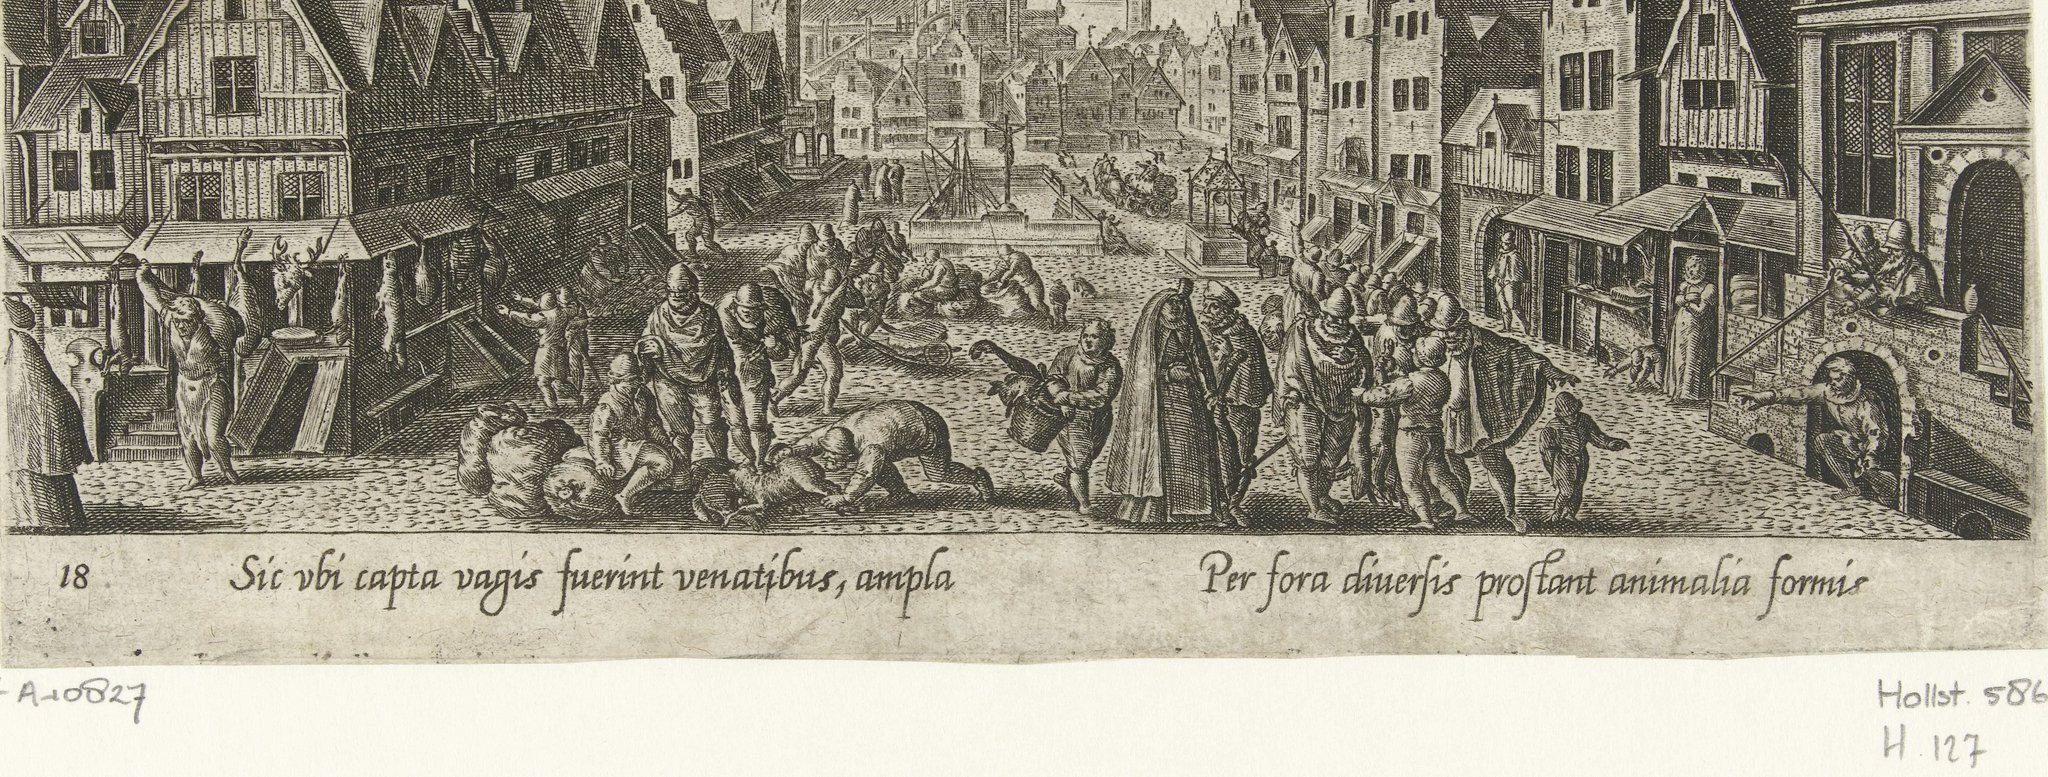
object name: print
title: Venationes, Piscationes et Aucupii Typi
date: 1582-1633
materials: paper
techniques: engraving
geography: antwerp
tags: butcher, slaughterman, market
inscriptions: collector's mark: Lugt 2228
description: Gezicht op een markt in een stad. Links een slager. Op de markt wordt handel gedreven in geslachte dieren en wild. De prent heeft een Latijns onderschrift en maakt deel uit van een serie van 54 prenten.